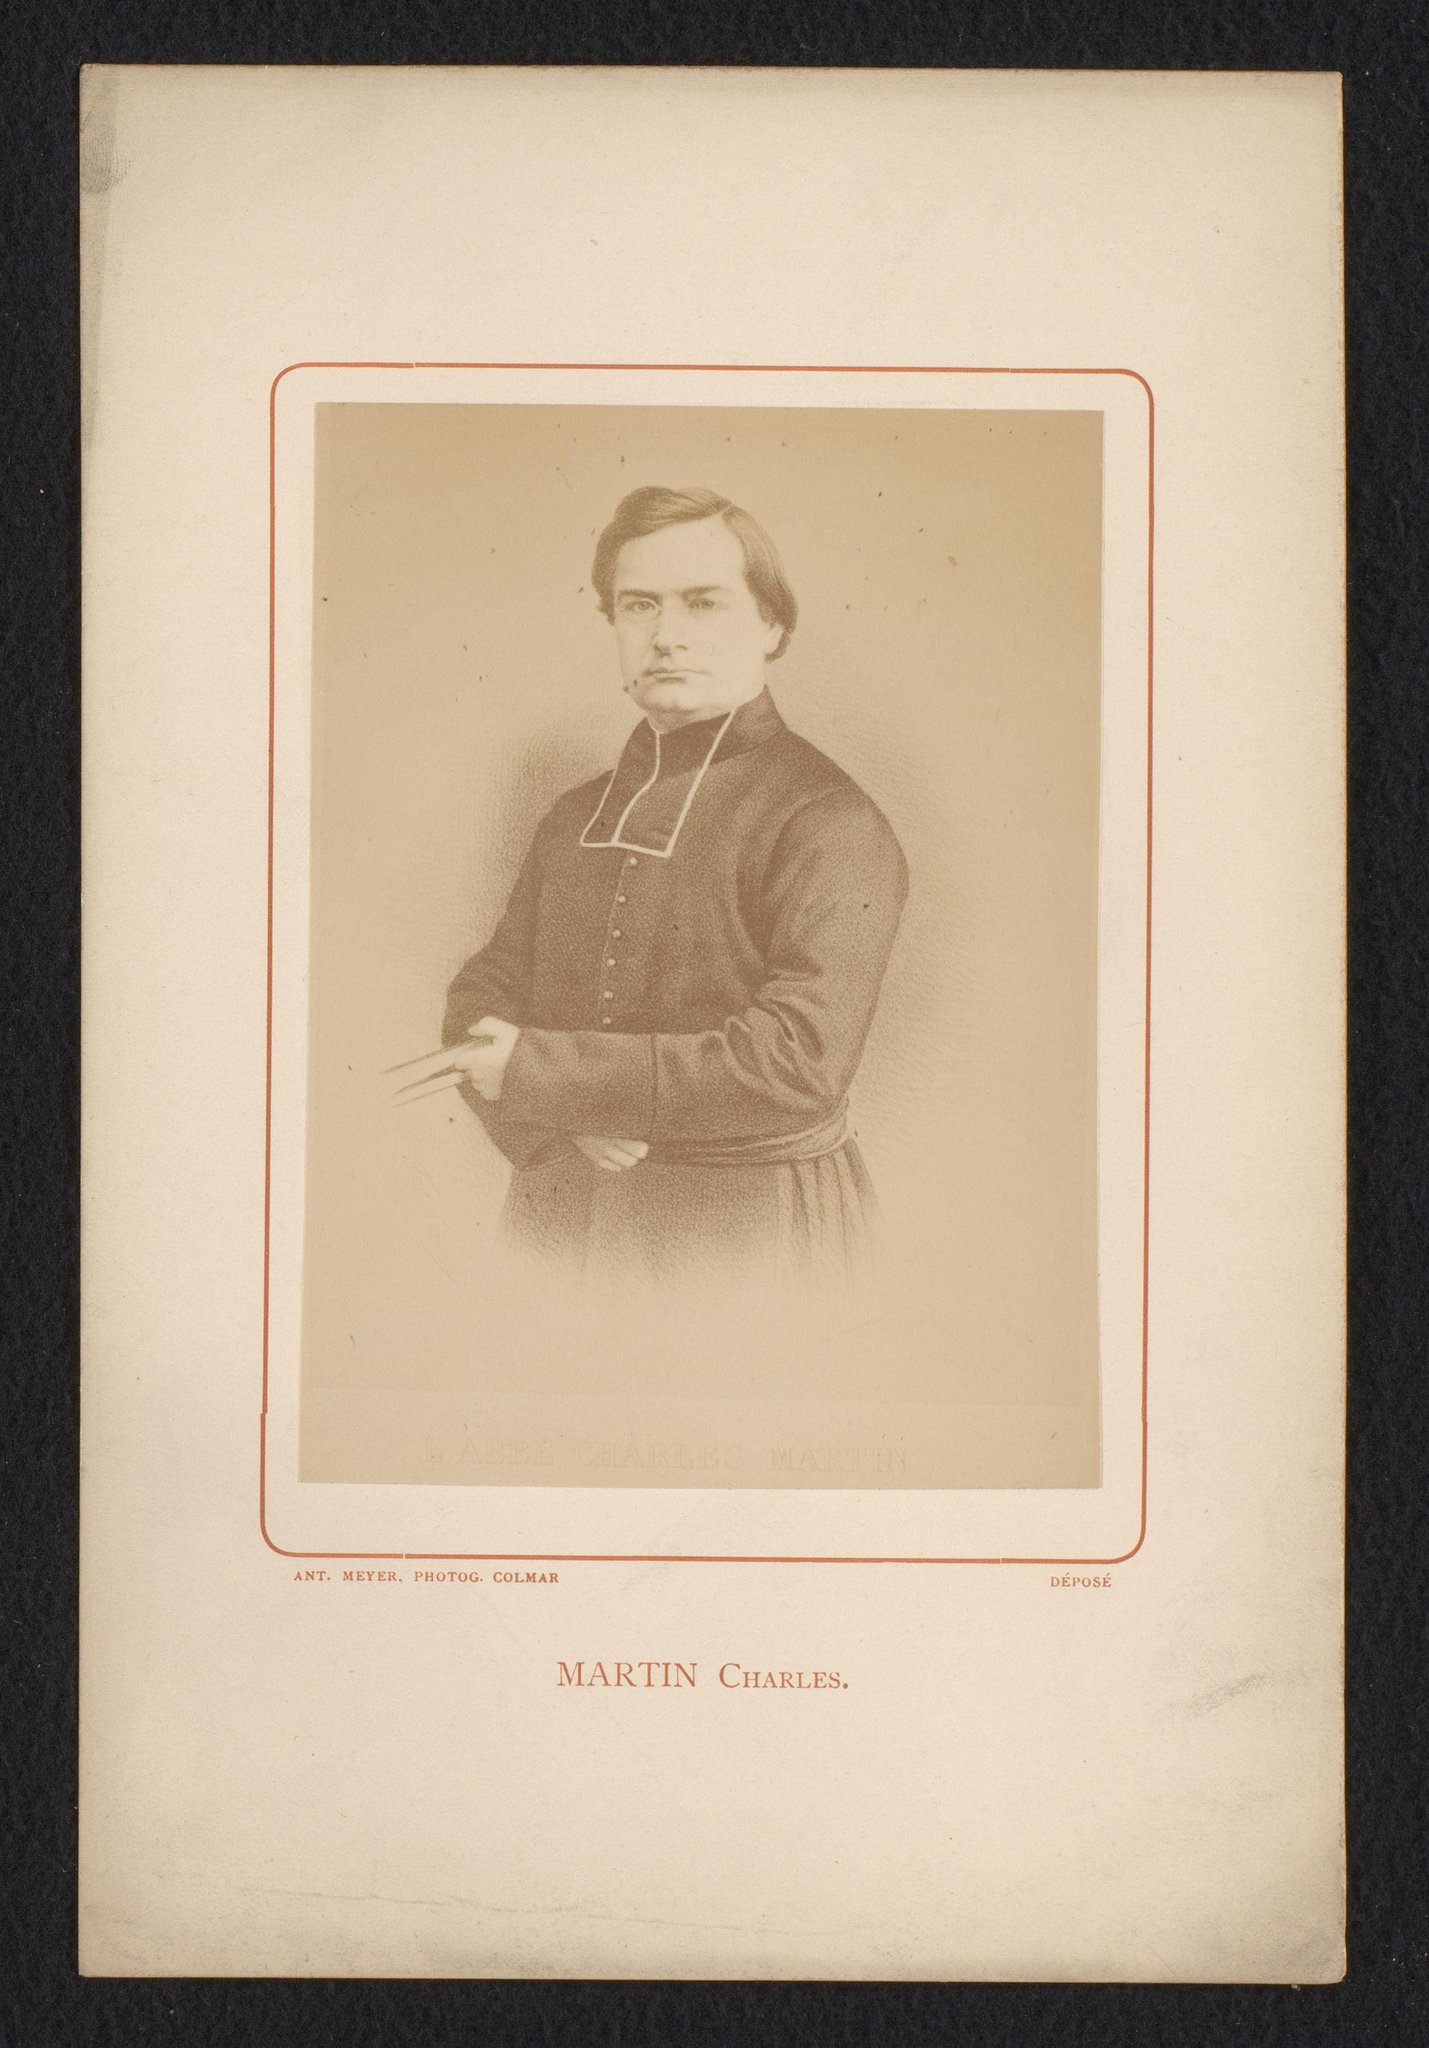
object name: photograph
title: Fotoreproductie van een prent van een portret van Charles Martin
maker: anton meyer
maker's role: fotograaf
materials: photographic support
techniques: albumen print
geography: colmar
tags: clergyman, theologian, historical persons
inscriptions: inscription: ‘Déposé’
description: Deze foto maakt deel uit van een omslag met 29 foto's op 29 bladen en 23 teksbladen.